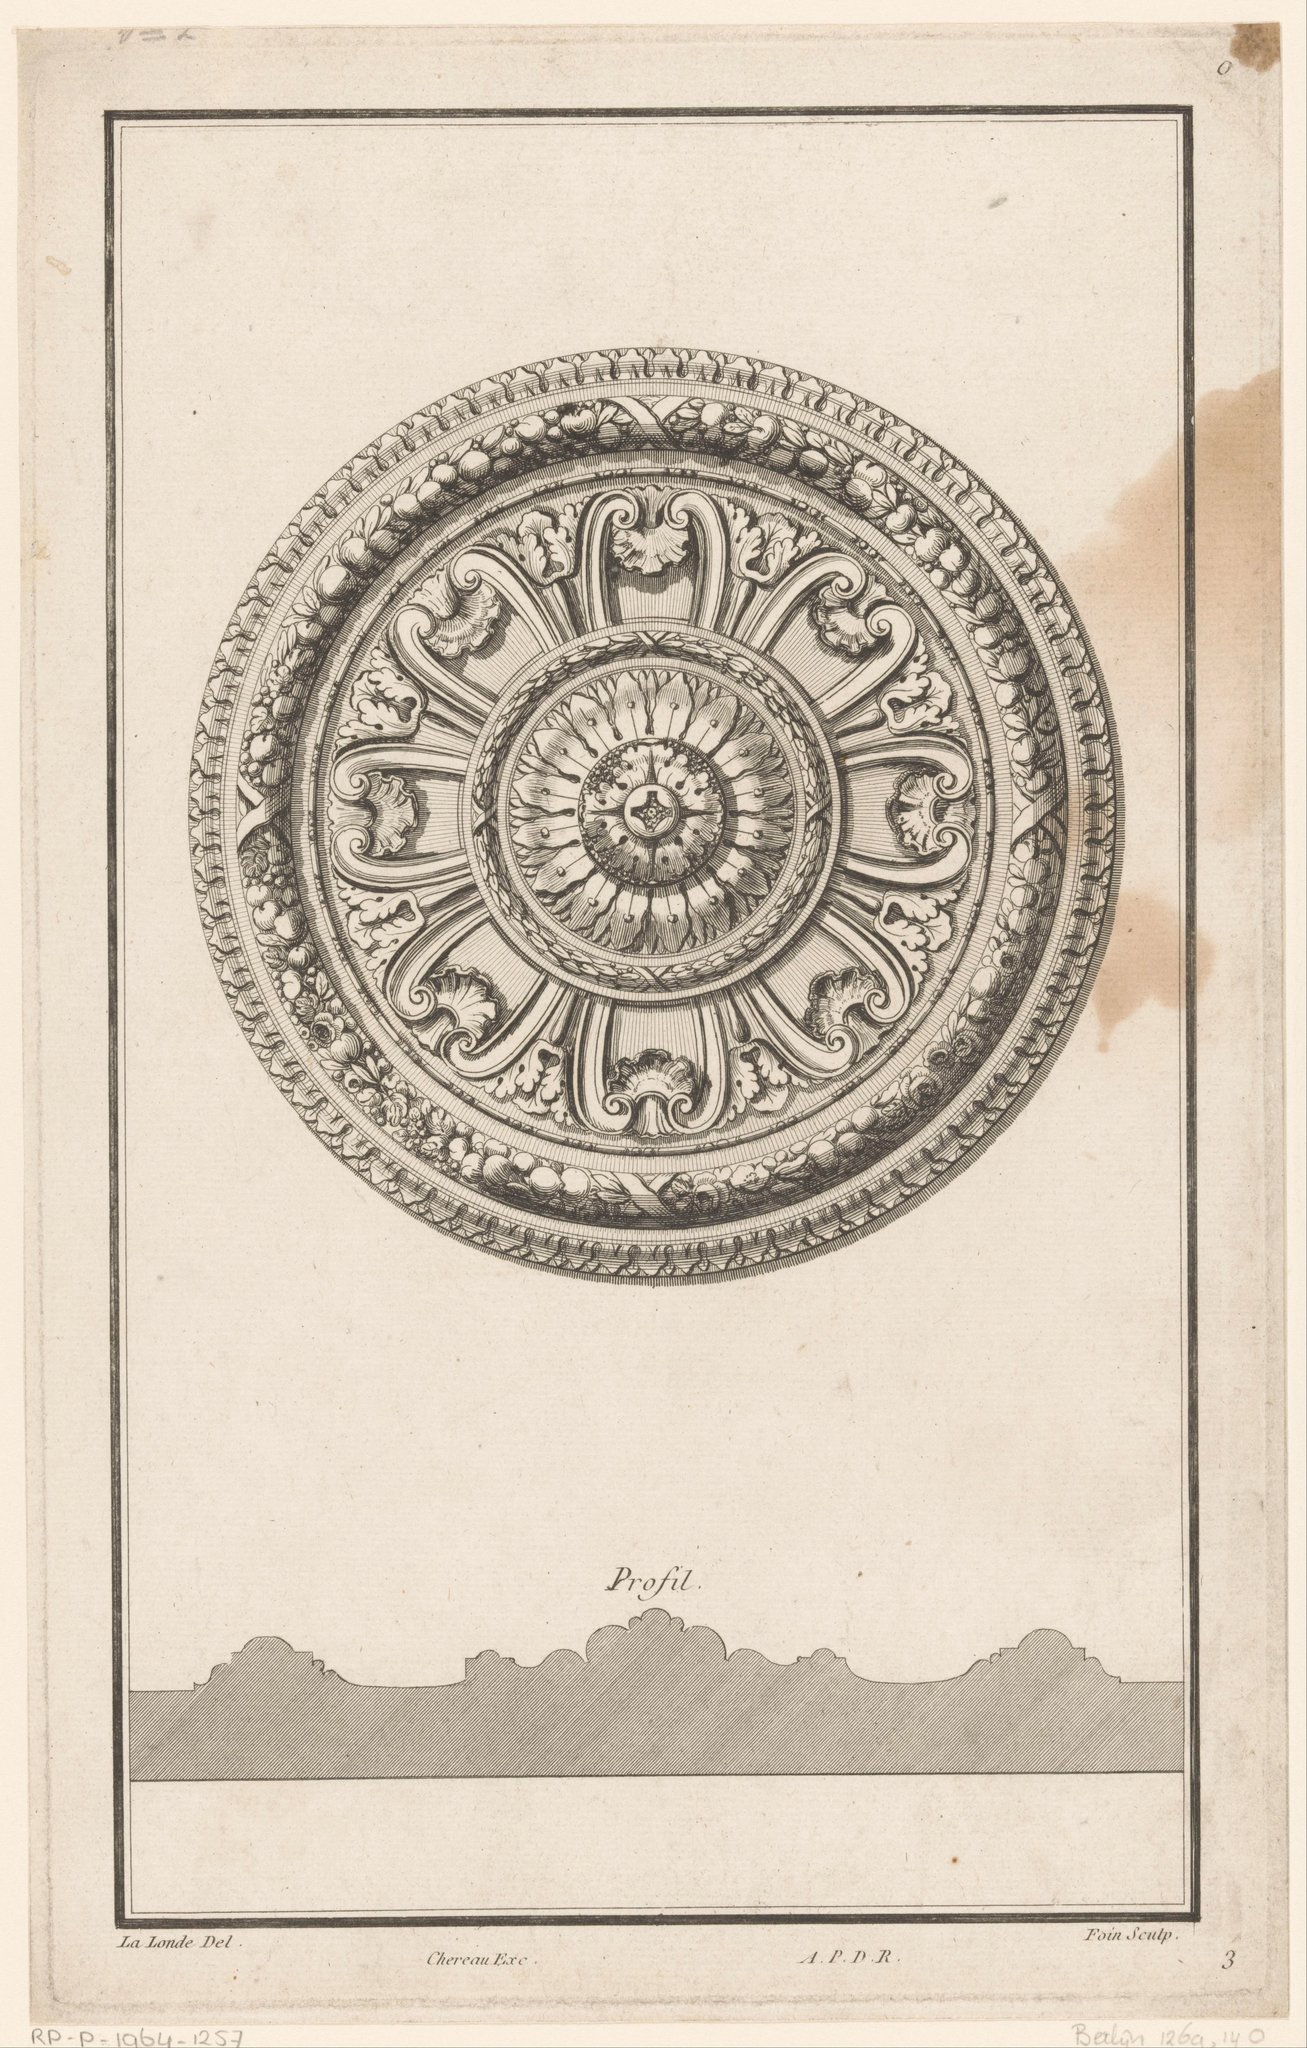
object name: ornament print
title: Rozet met rocailles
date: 1784-1785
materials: paper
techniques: engraving, etching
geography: paris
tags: rosette ~ ornament, rocaille ornament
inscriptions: collector's mark: Lugt 2760, collector's mark: Lugt 2228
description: Rozet met bloemmotief, rocailles en bladmotieven en een rand met bloemmotieven en fruit. Daaronder het profiel van de rozet.